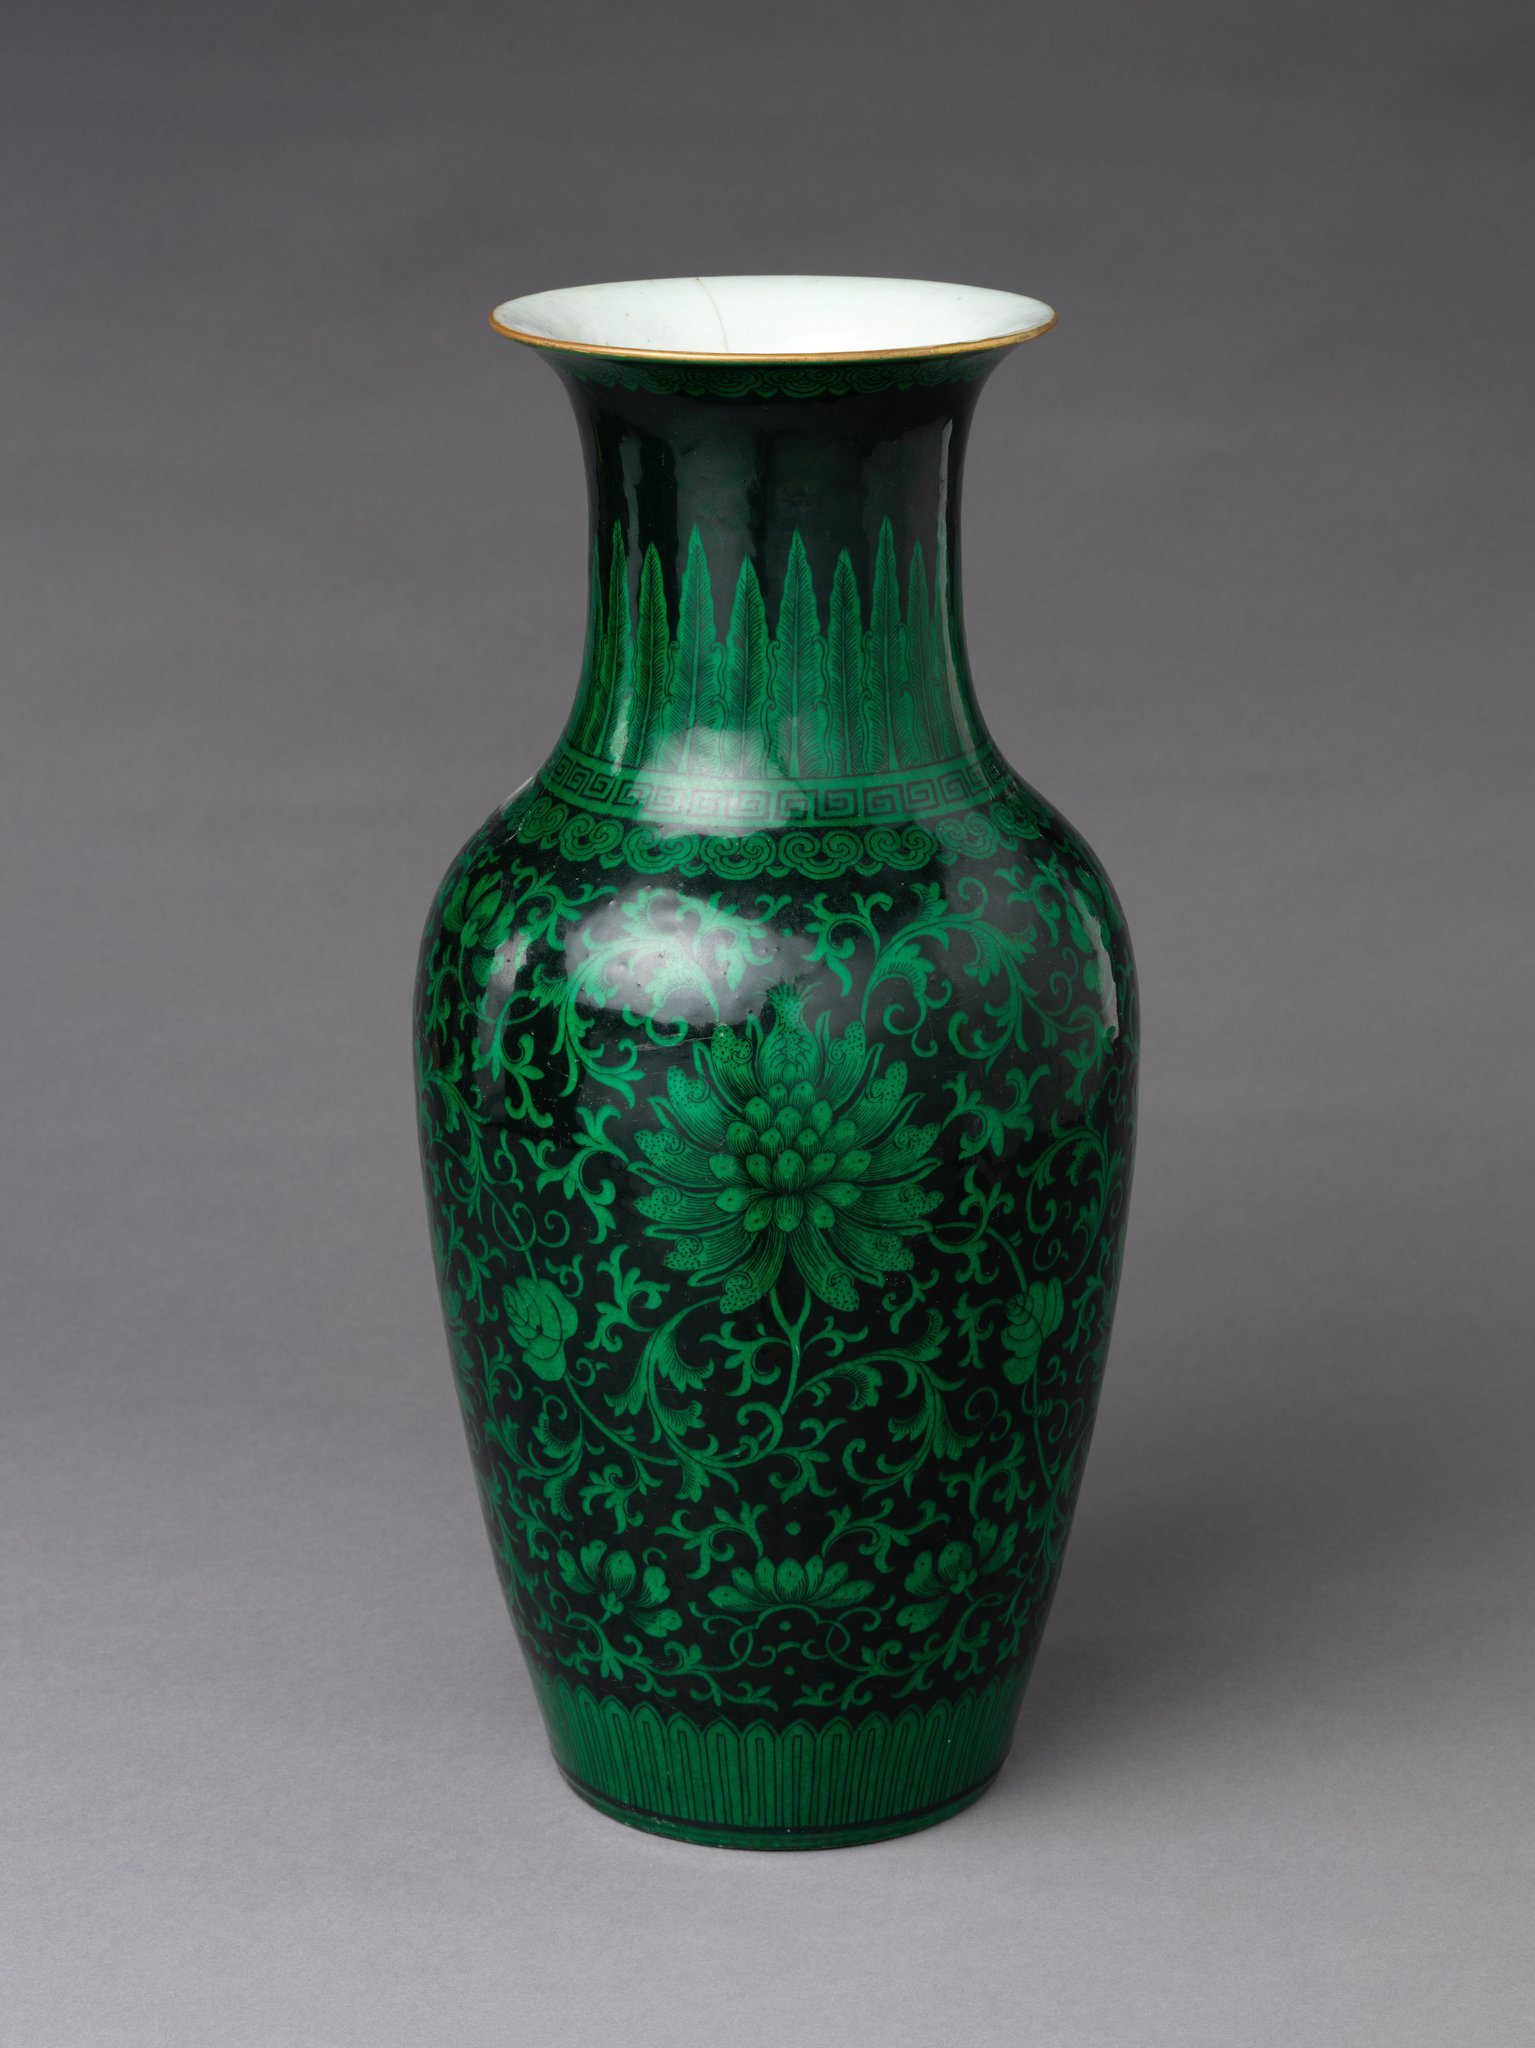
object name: vase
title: Vase with floral scrolls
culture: chinese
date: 1767-1800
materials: enamel, porcelain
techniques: painting